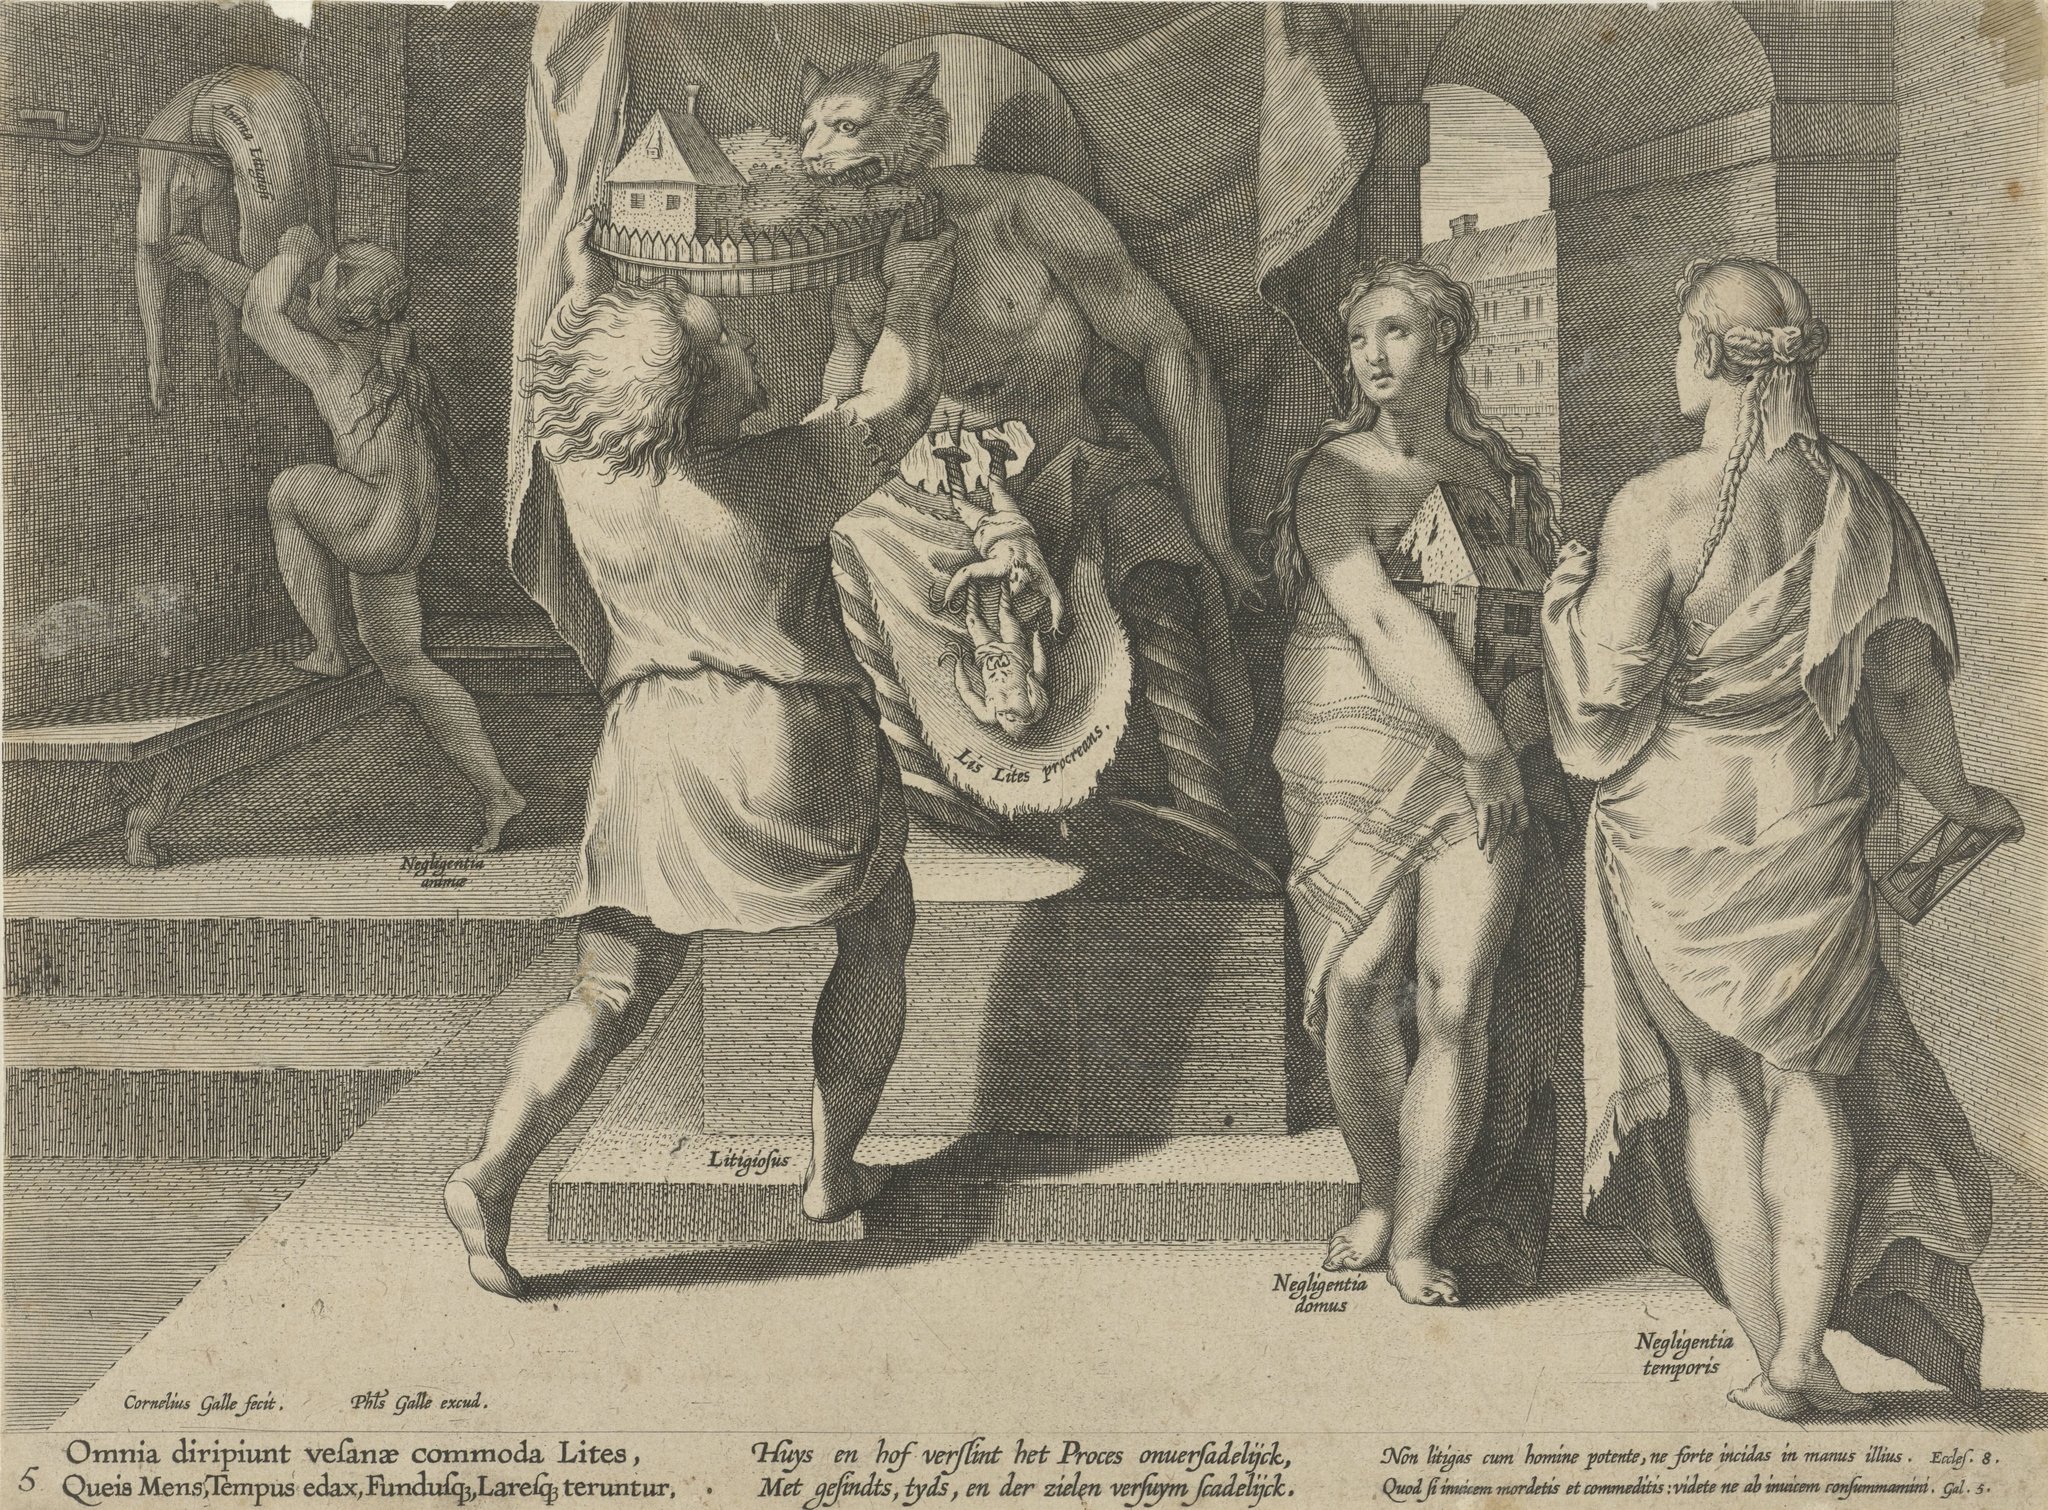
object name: print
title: Litis Abusus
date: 1593-1597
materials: paper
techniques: engraving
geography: antwerp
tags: allegorical representations of the effects of time, tort; legal abuse; judicial murder (+ abuse of legal power), neglected dwelling (+ variant), litigation, legal proceedings, lawsuit (+ variant)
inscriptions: collector's mark: Lugt 2228, collector's mark: ‘Corneille Galle. Dit le vieuf grave nr. Estampe en Anvers. Cet habile artiste travaille long temps a Nome. Il surpasse tous les Galle par la beaute de sa gravure et la correction de son dervir’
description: De personificatie Procesvorming (Lis), een man met een wolvenkop, een hellemond als buik en schroeven als poten zit op een troon. Hij verslindt een huis dat hem wordt aangeboden door een aanklager (Litigiosus). Naast de troon staan de personificaties Verwaarlozing van Huizen (Negligentia domus) en Tijdsverkwisting (Negligentia temporis). Verwaarlozing van de ziel (Negligentia animae) legt de ziel van de aanklager (Anima Litigiosus) over een rek. De prent heeft drie onderschriften (twee in het Latijn en een in het Nederlands) en maakt deel uit van een achtdelige serie over de misbruiken in procesvoering.